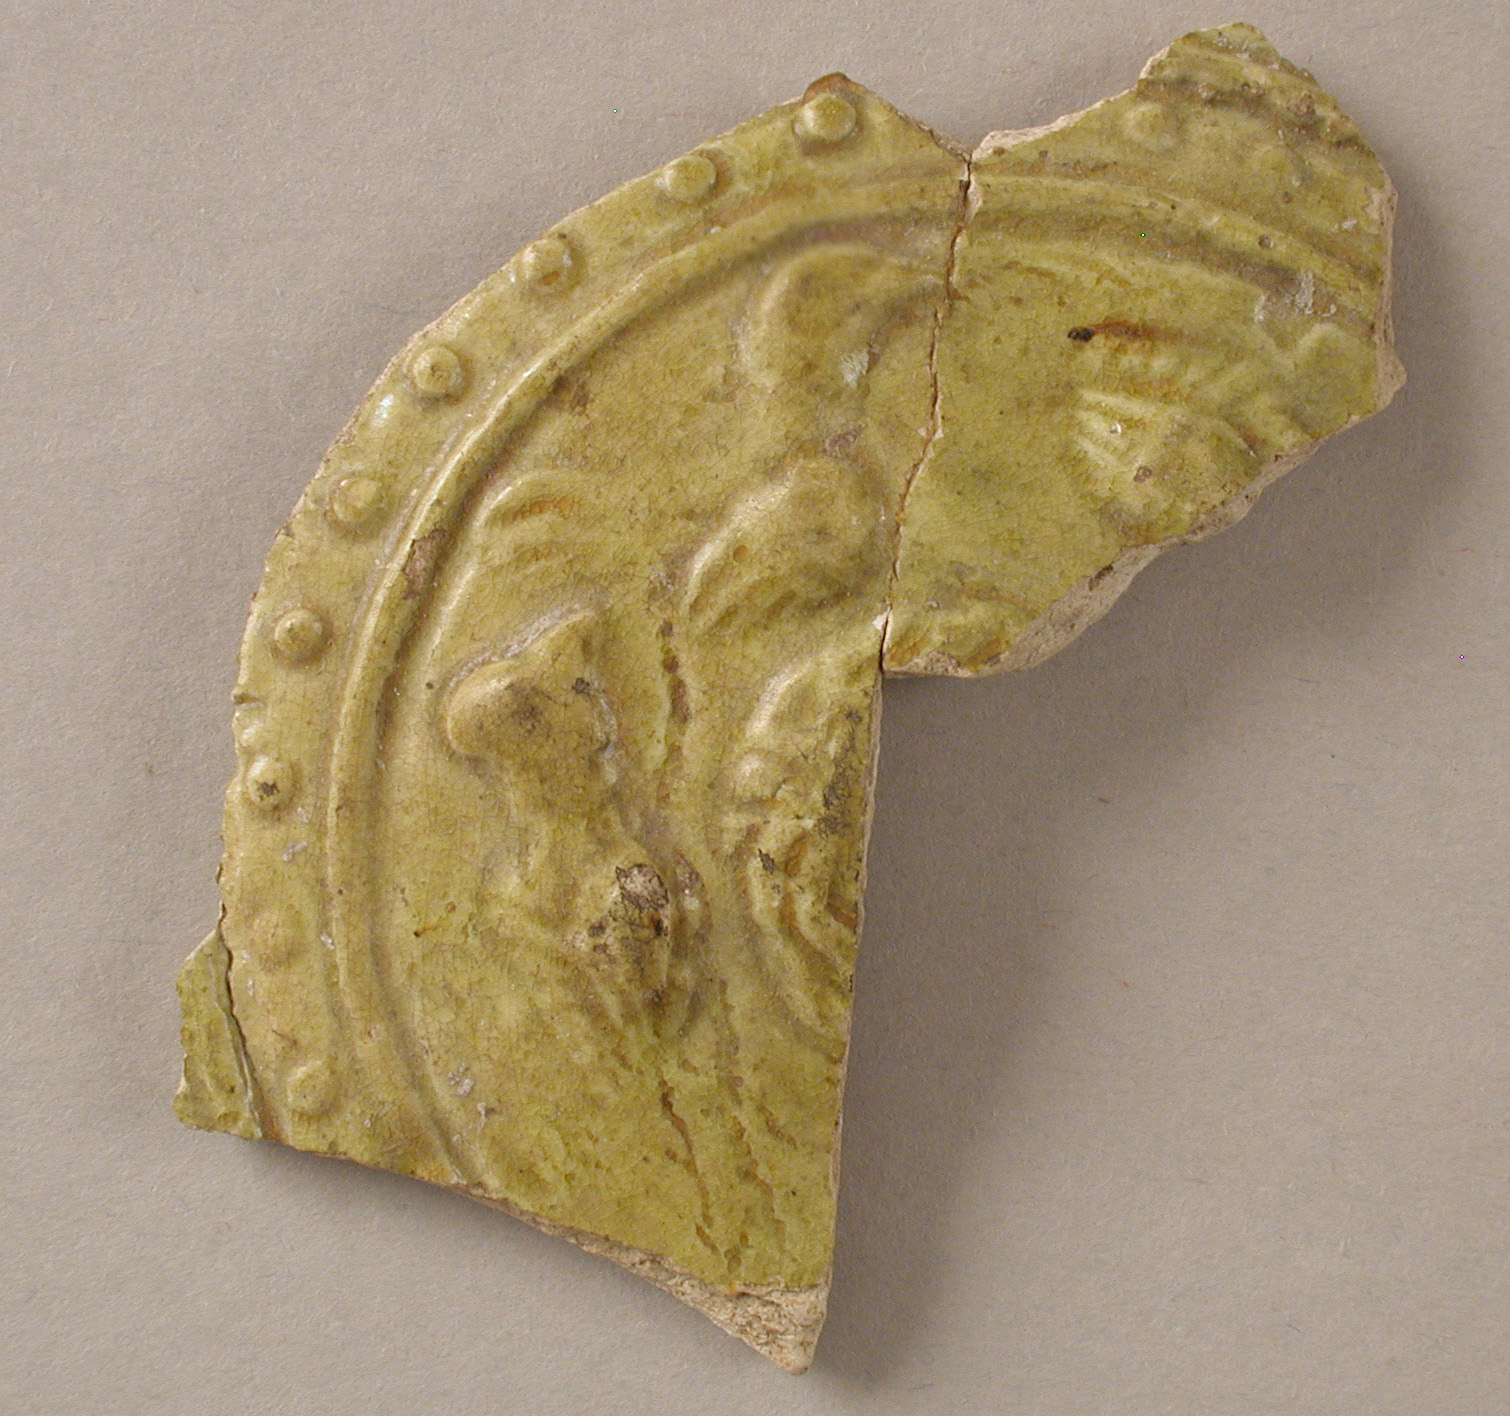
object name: fragment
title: Pilgrim Bottle Fragment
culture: visigothic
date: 801-900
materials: earthenware, glaze